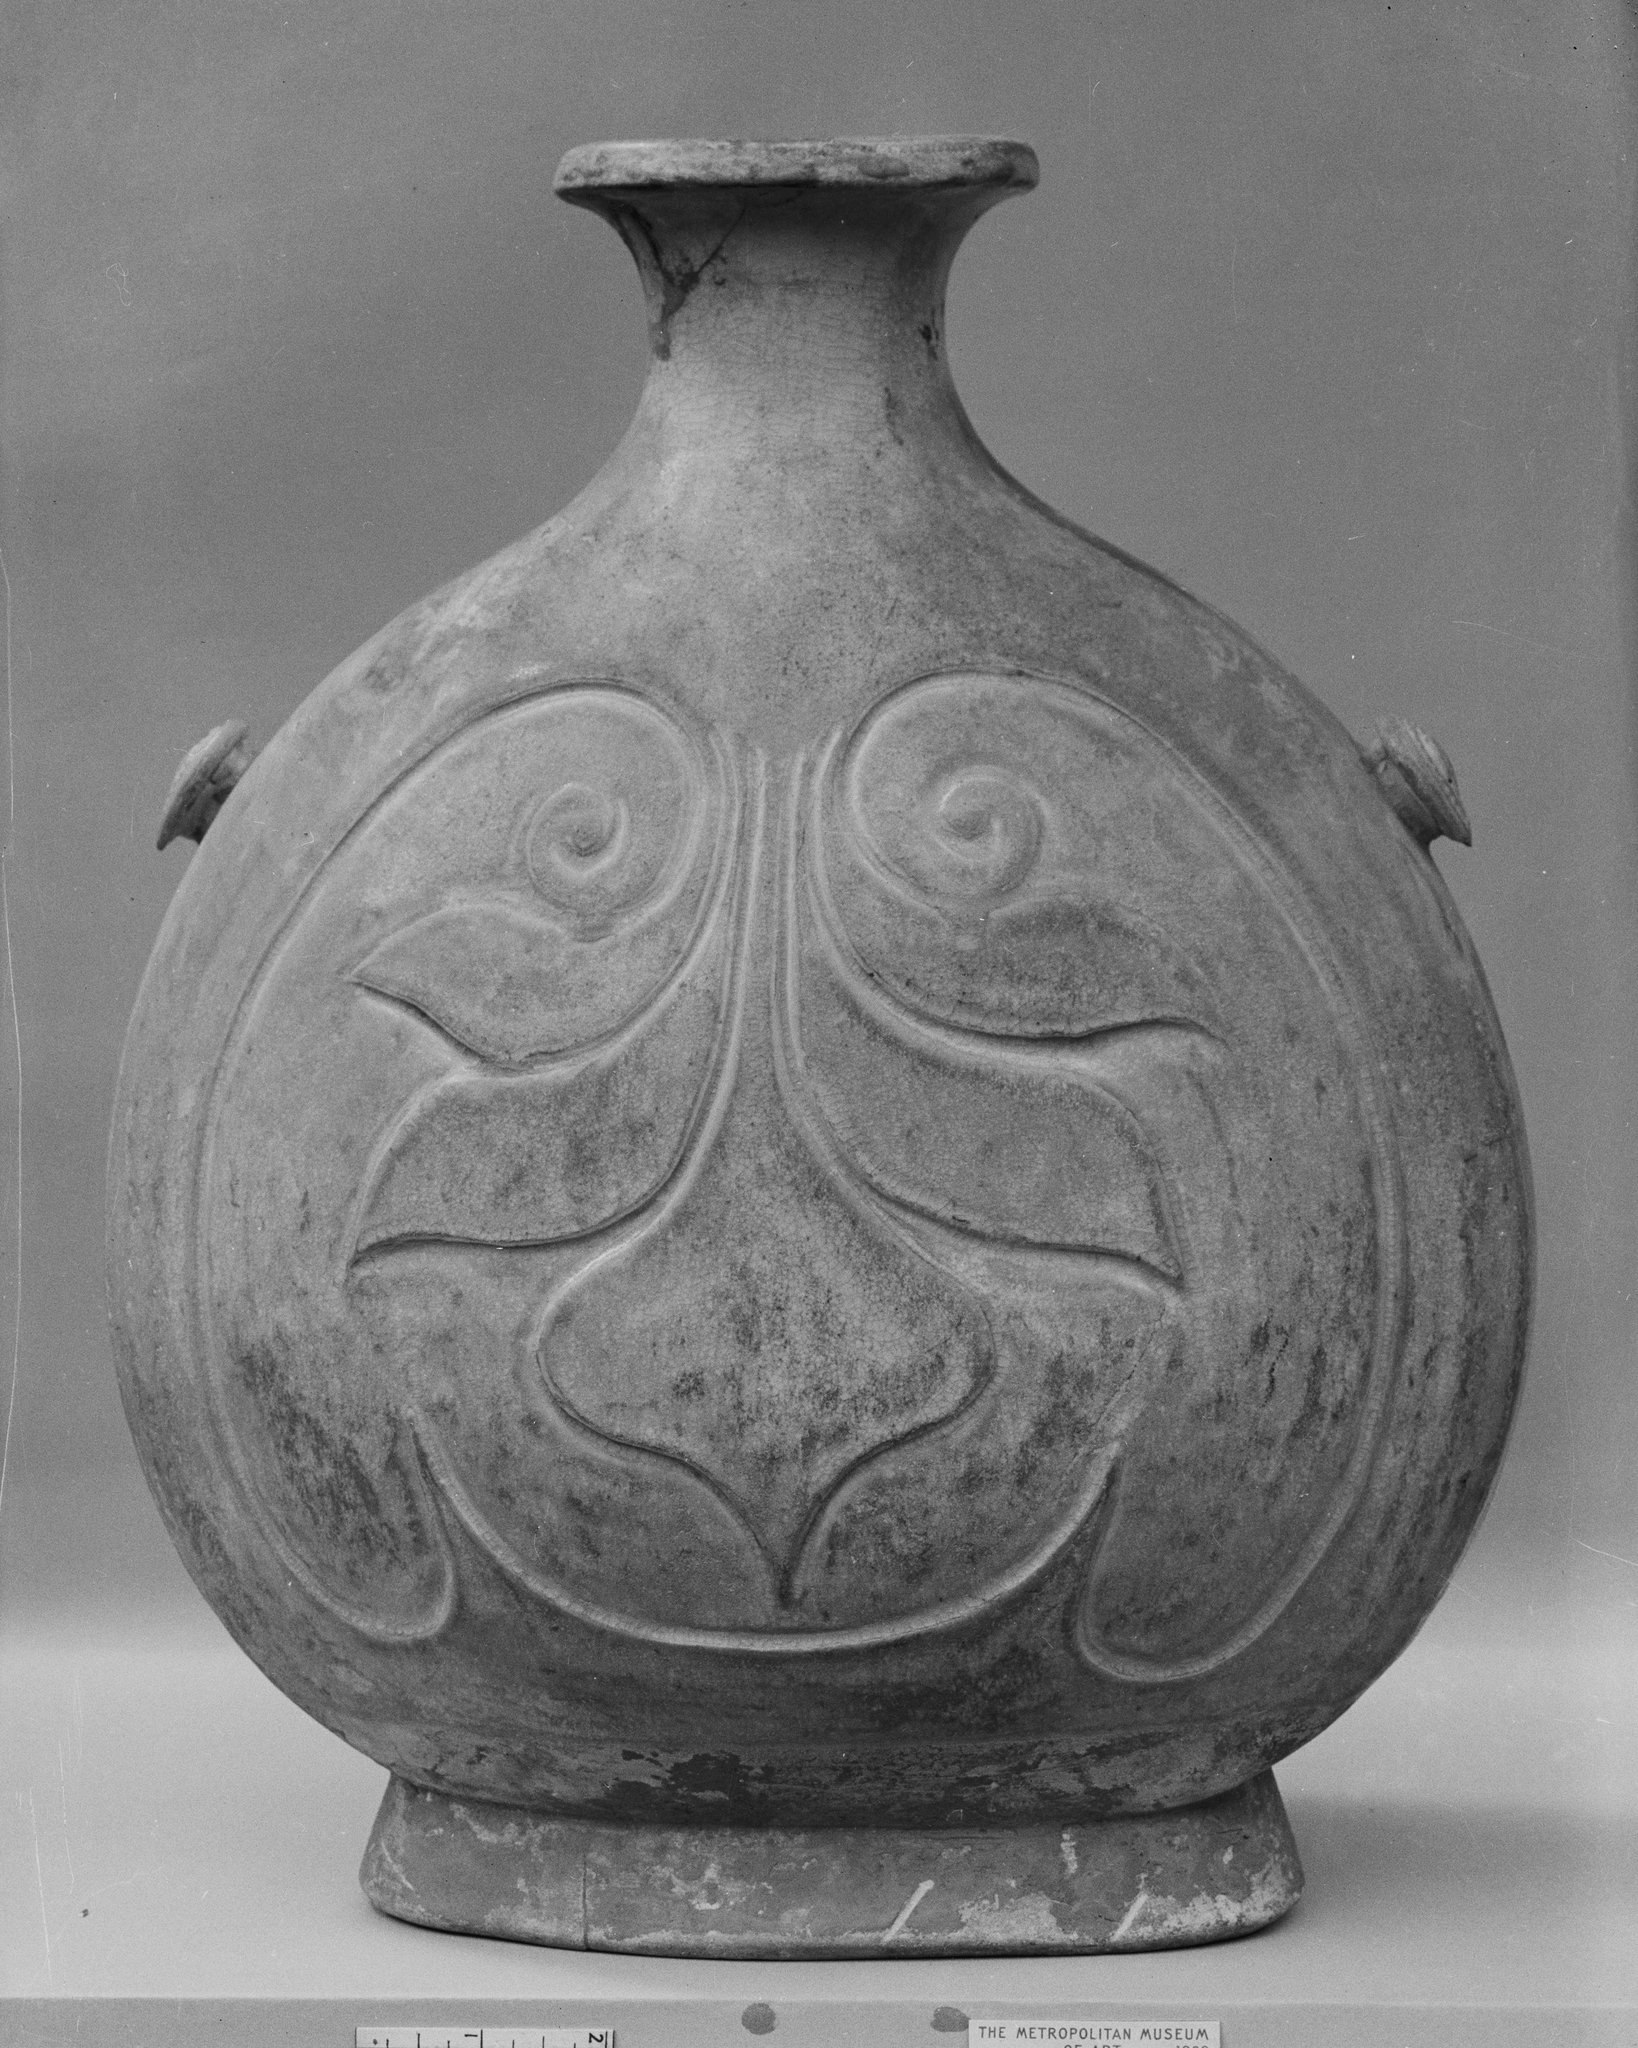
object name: pilgrim bottle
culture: chinese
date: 618-907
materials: pottery